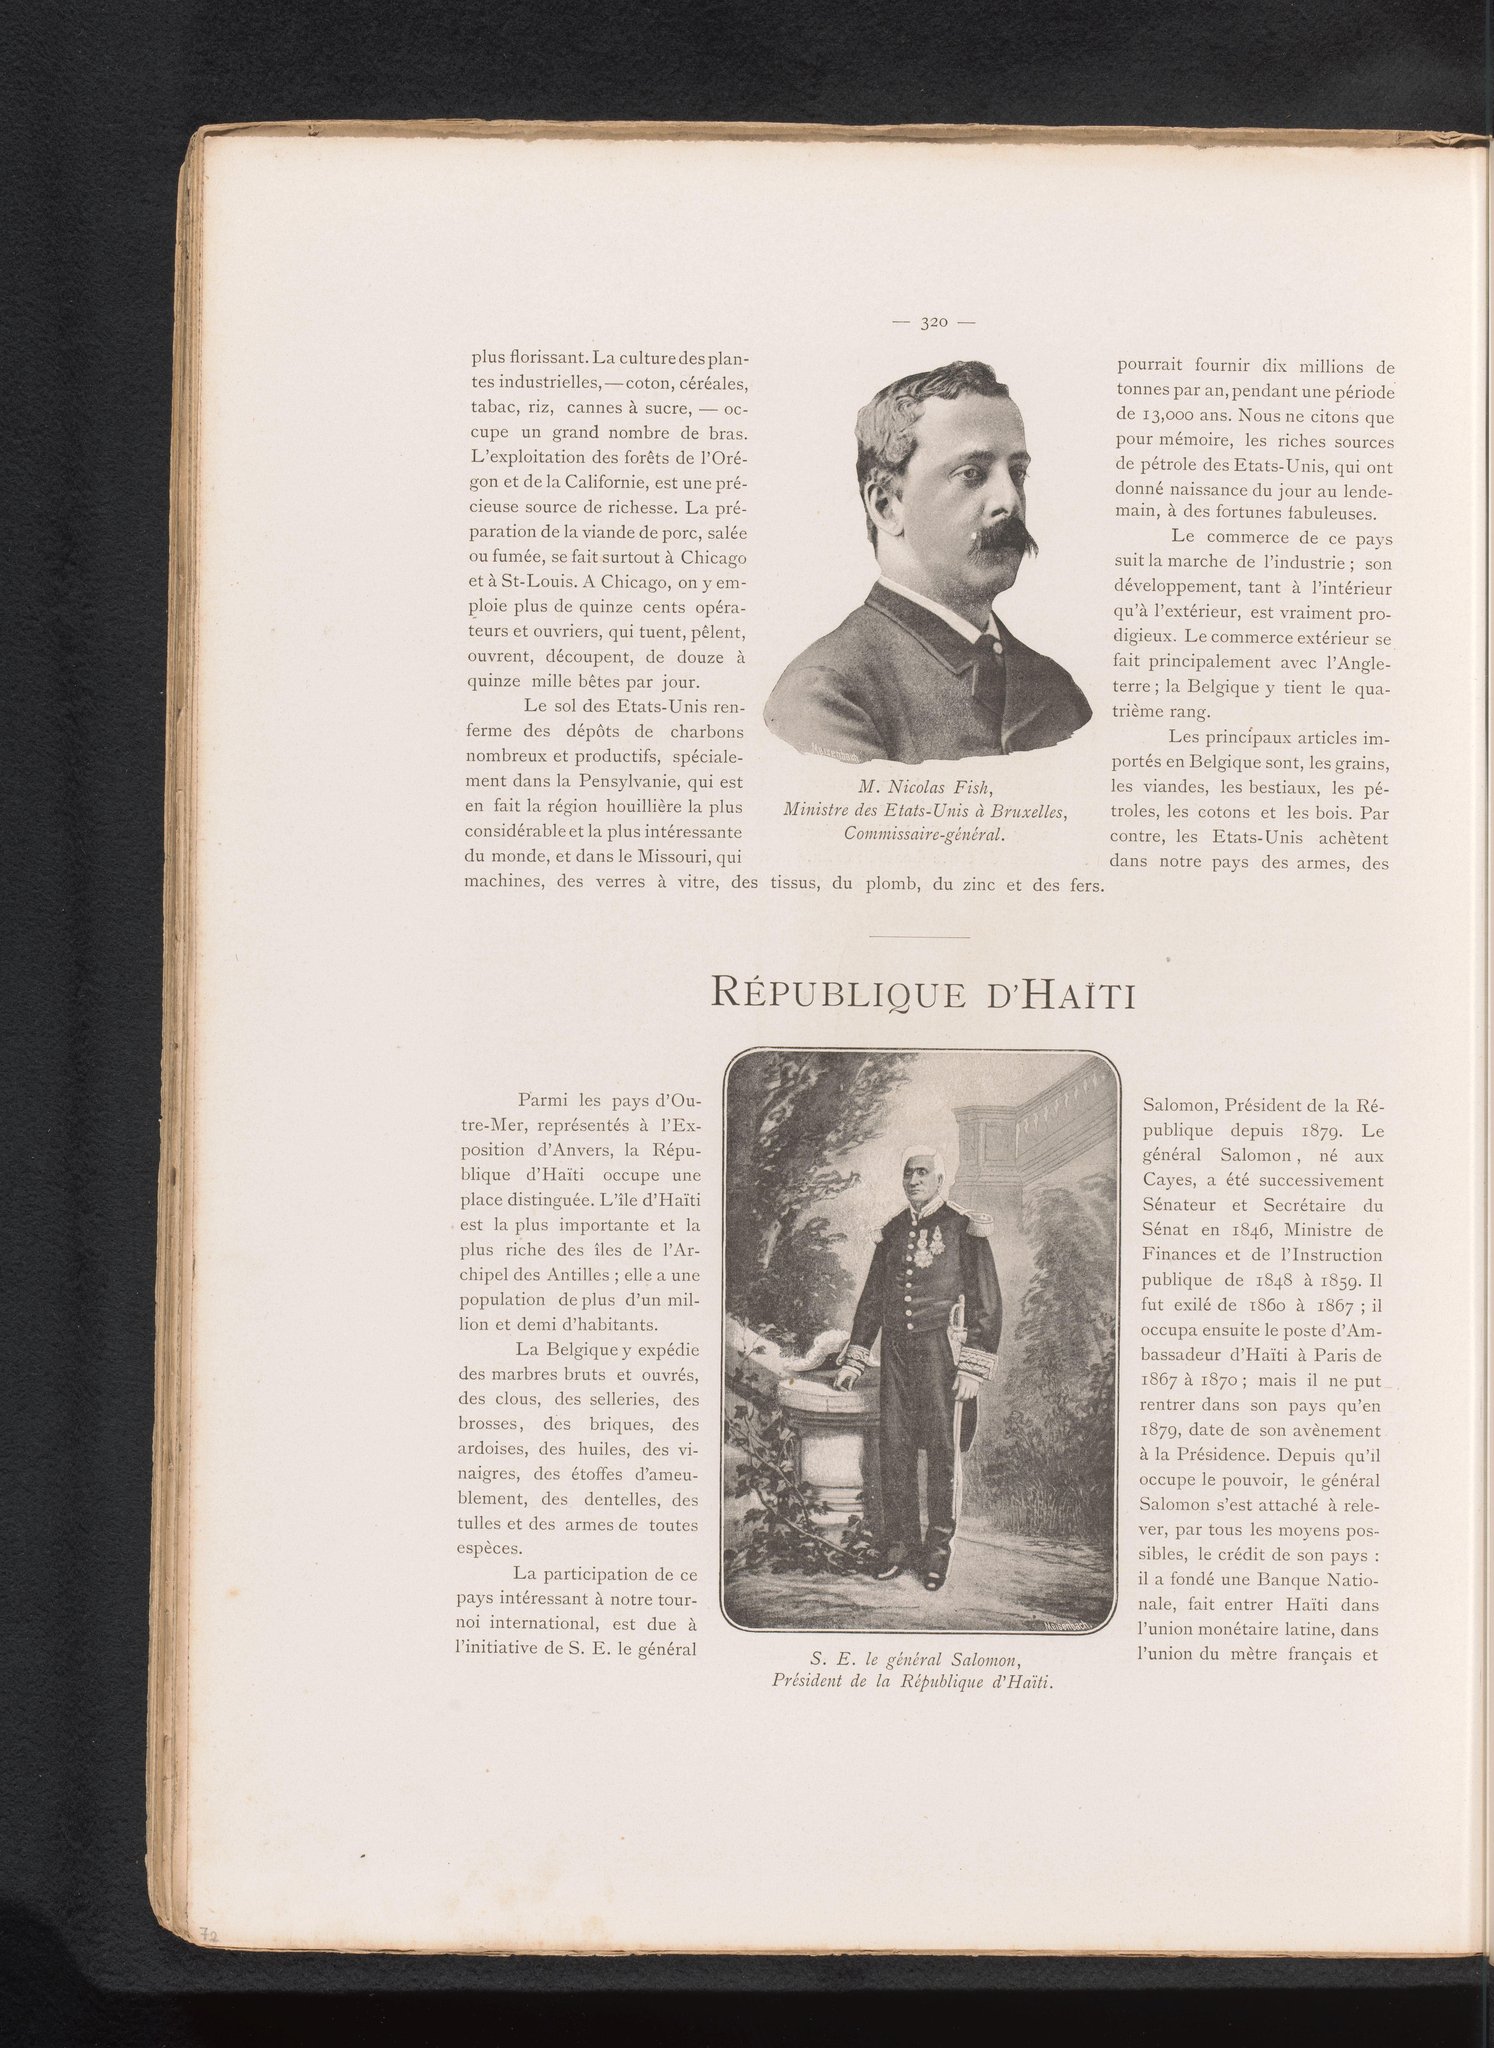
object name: photomechanical print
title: M. Nicolas Fish, Ministre des Etats-Unis à Bruxelles, Commissaire-général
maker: Anonymous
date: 1880-1885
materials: paper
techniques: autotype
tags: paris, politician, president ~ head of republic, historical persons